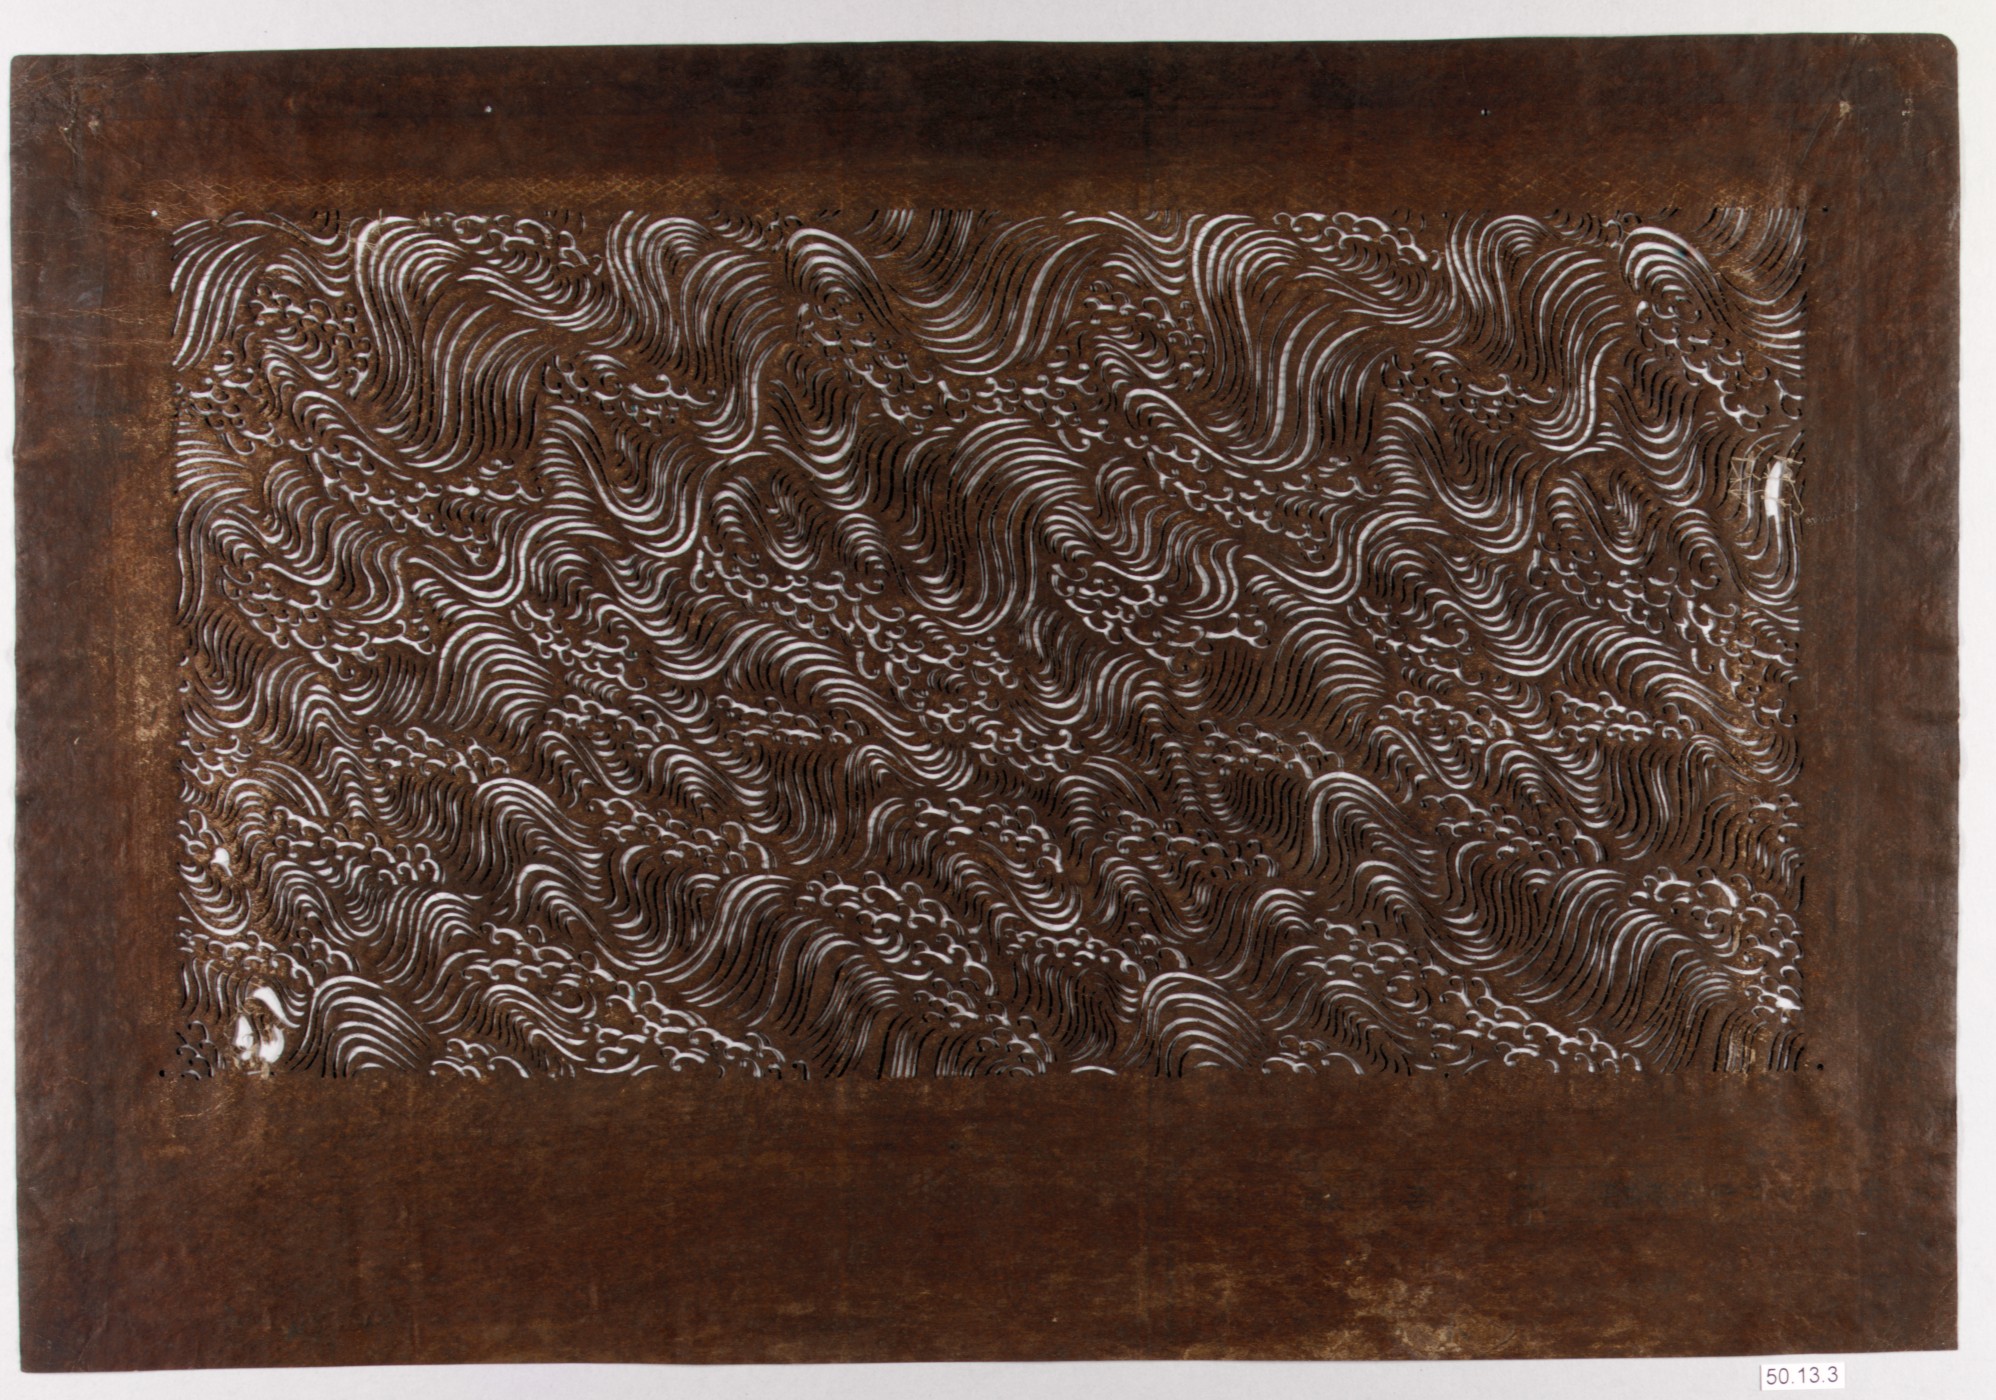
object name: stencil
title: Stencil with Pattern of Turbulent Water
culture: japanese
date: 1801-1900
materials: paper, silk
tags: waves